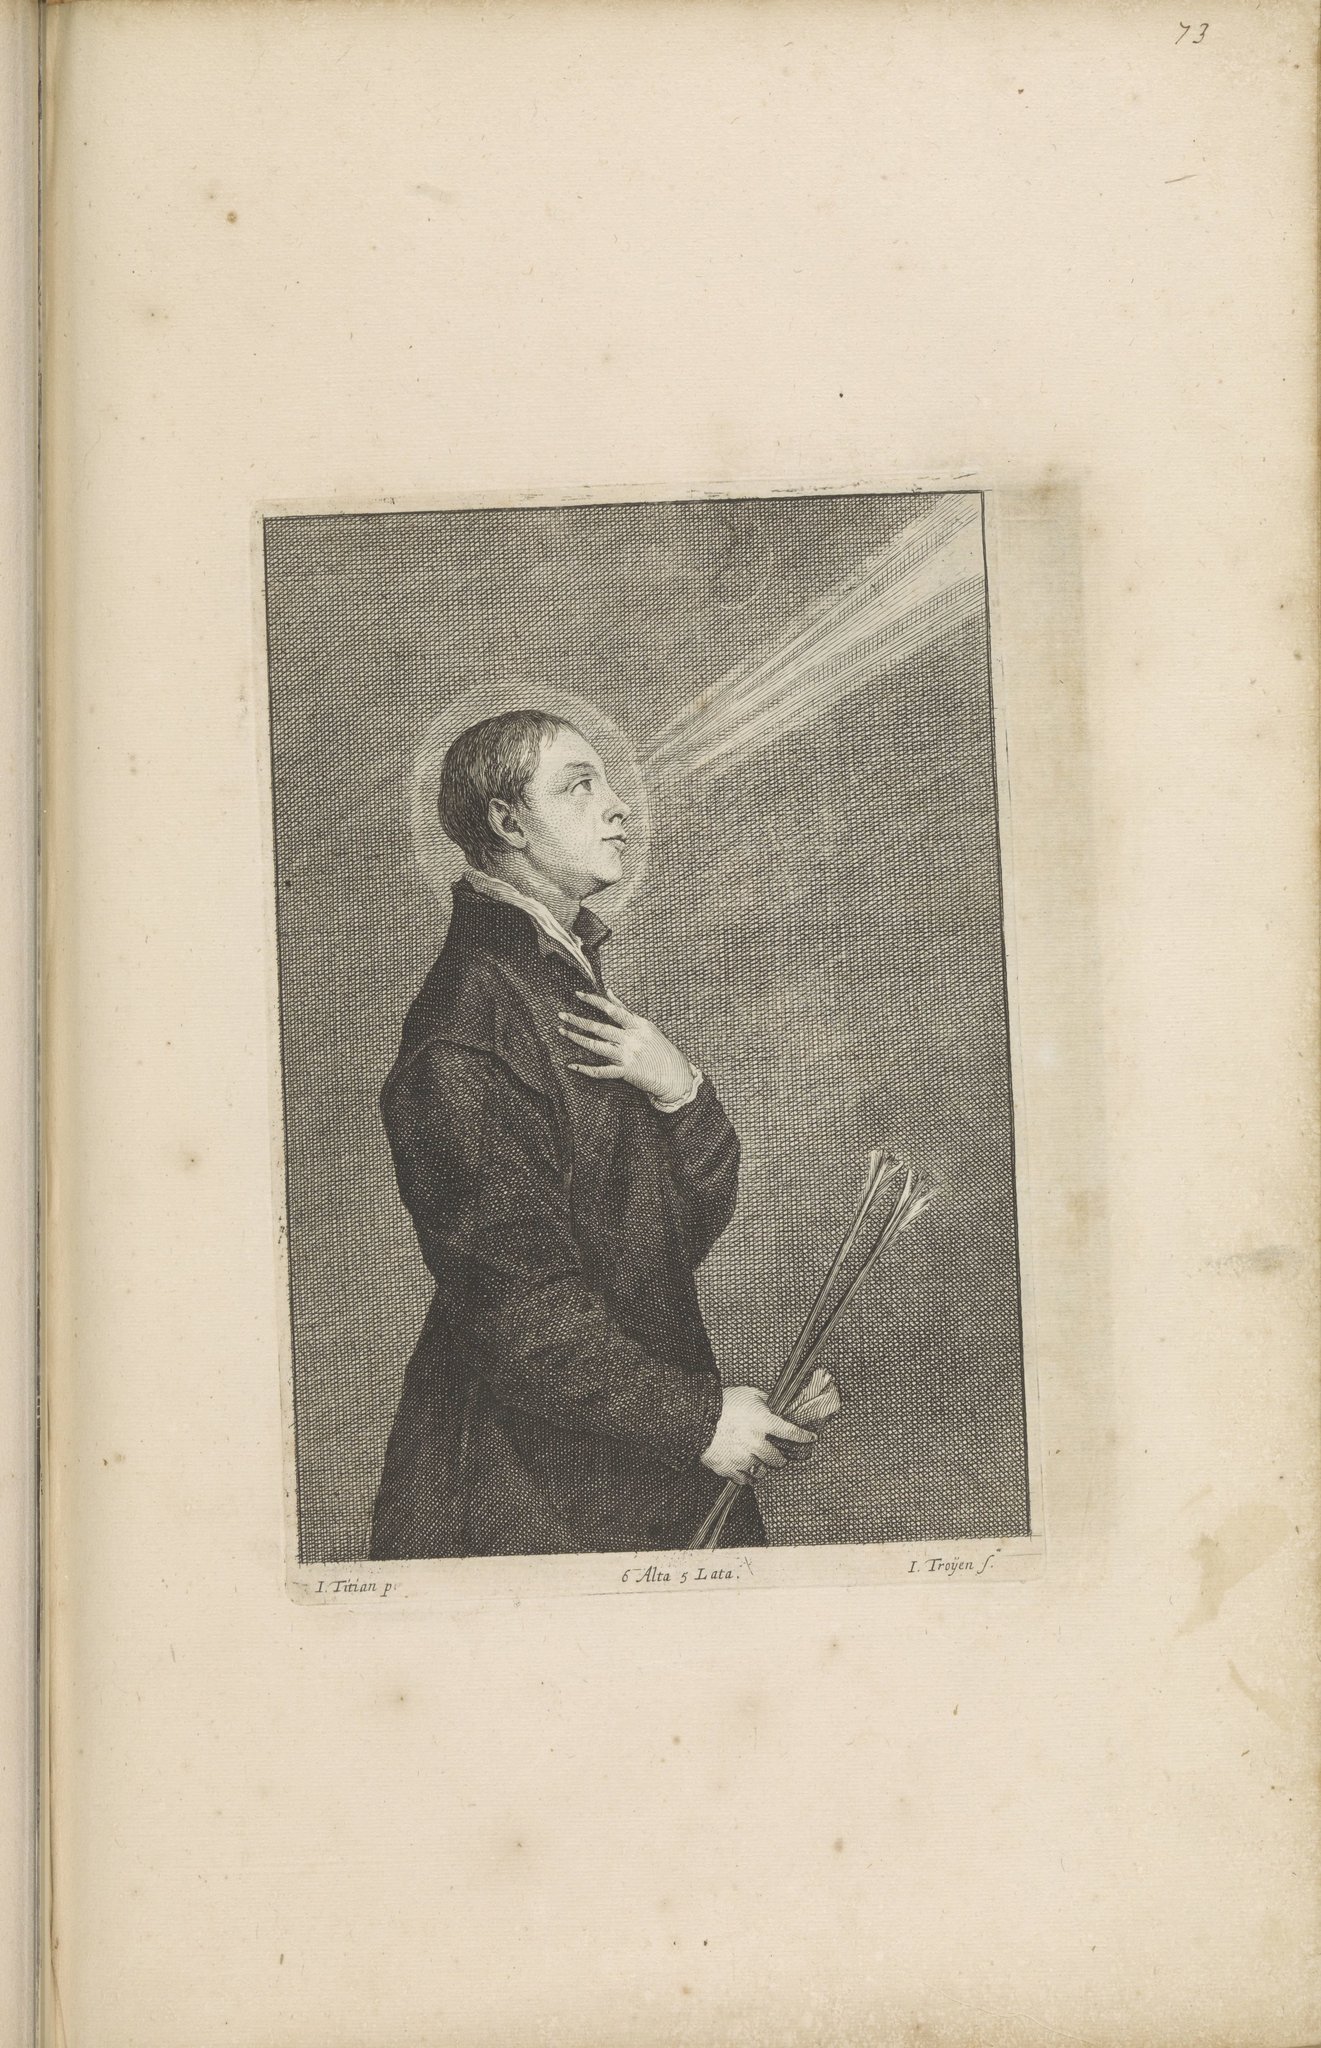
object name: album leaf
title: Portret van een man als de H. Sebastiaan, mogelijk de zoon van Francesco Filetto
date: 1660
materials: paper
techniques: engraving, etching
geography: brussels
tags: the martyr sebastian; possible attributes: arrow(s), bow, tree-trunk, historical persons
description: De prent is vervaardigd naar het schilderij van Titiaan dat zich in de collectie van het Kunsthistorisches Museum te Wenen bevindt (inventarisnummer: GG_84). David Teniers heeft waarschijnlijk van alle schilderijen uit de collectie van Leopold Willem van Oostenrijk een olieverfstudie op doek of paneel vervaardigd (zgn. pasticcio), die als voorbeeld voor de prentmakers diende. Het is niet altijd duidelijk of de pasticci door hem zijn gemaakt of door zijn atelier. Niet alle pasticci zijn overgeleverd.